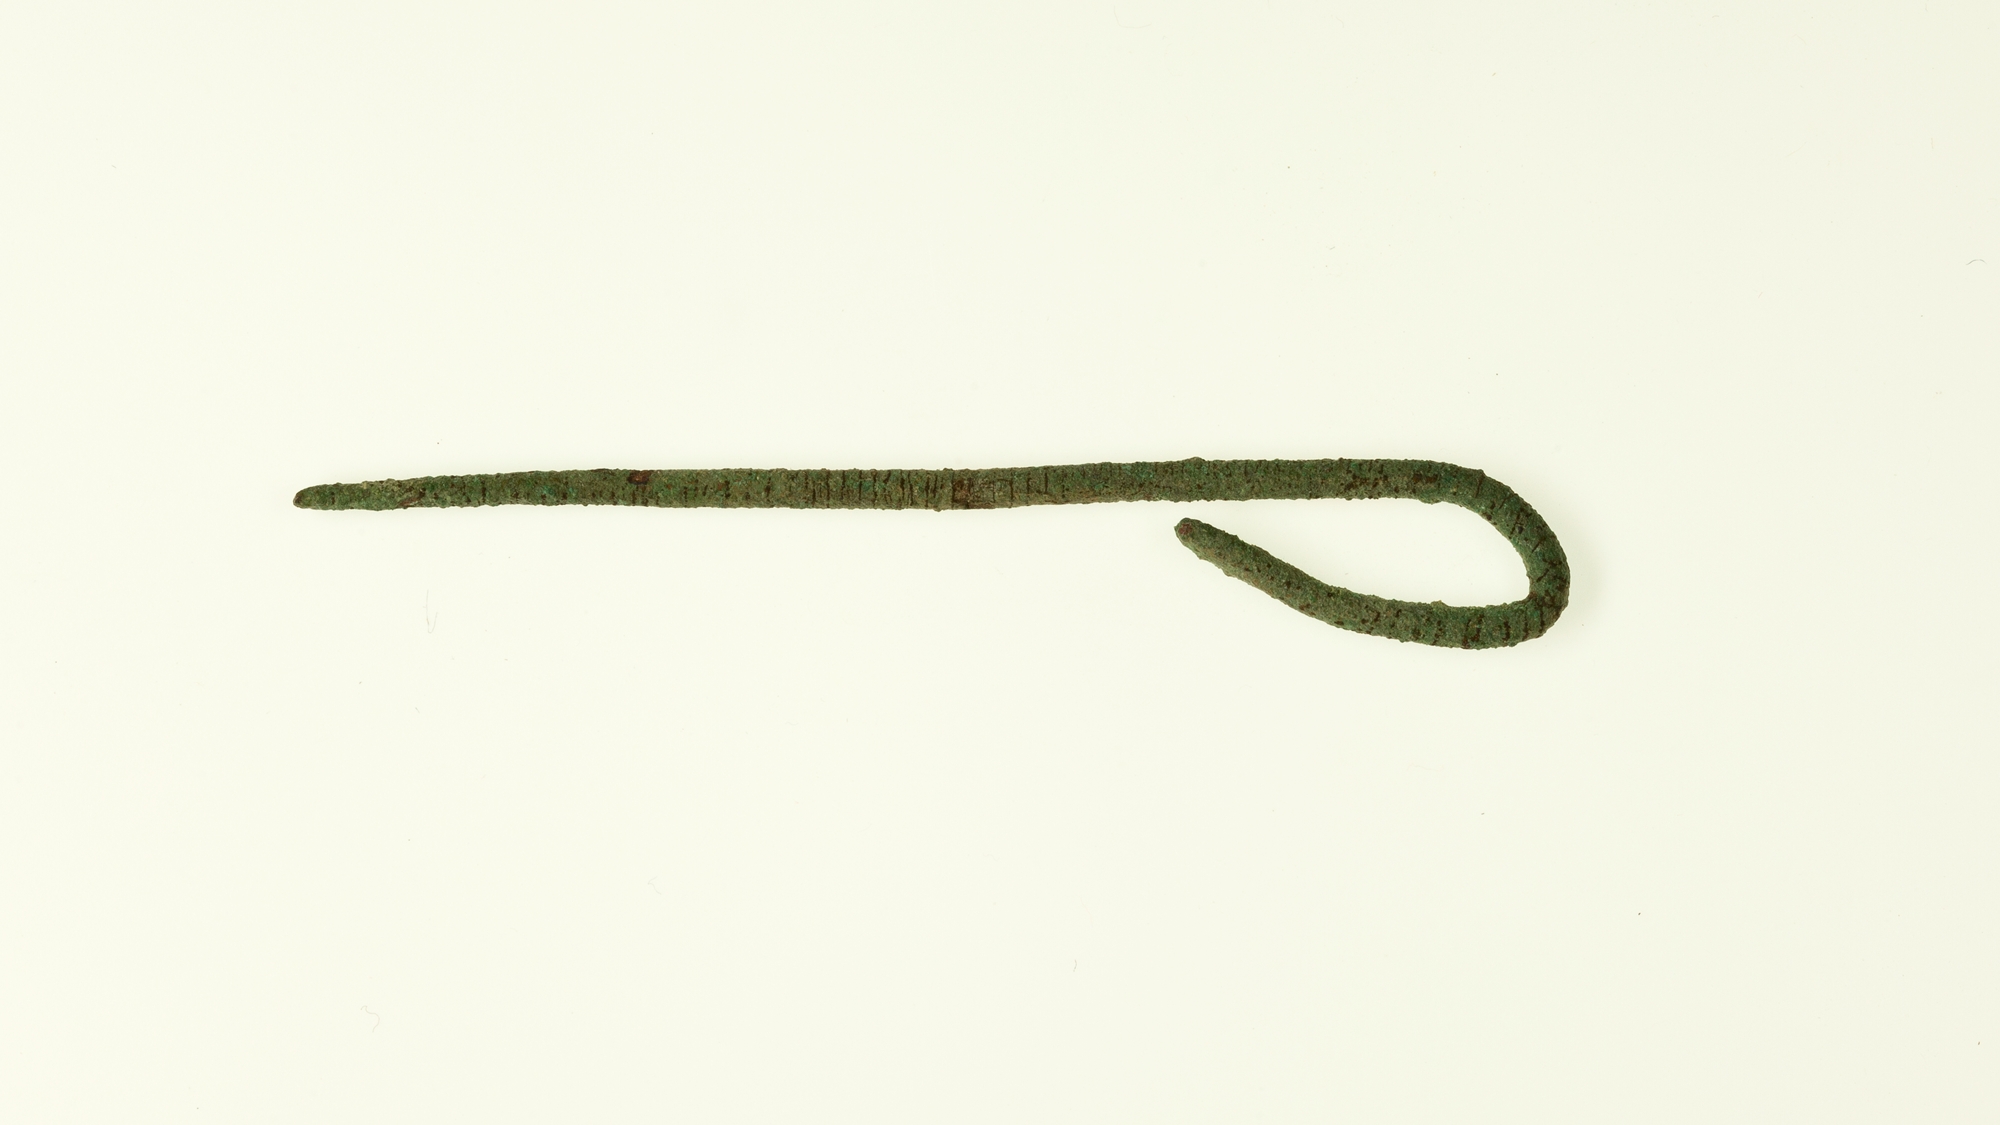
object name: hook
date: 1295-1070 BCE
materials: bronze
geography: egypt